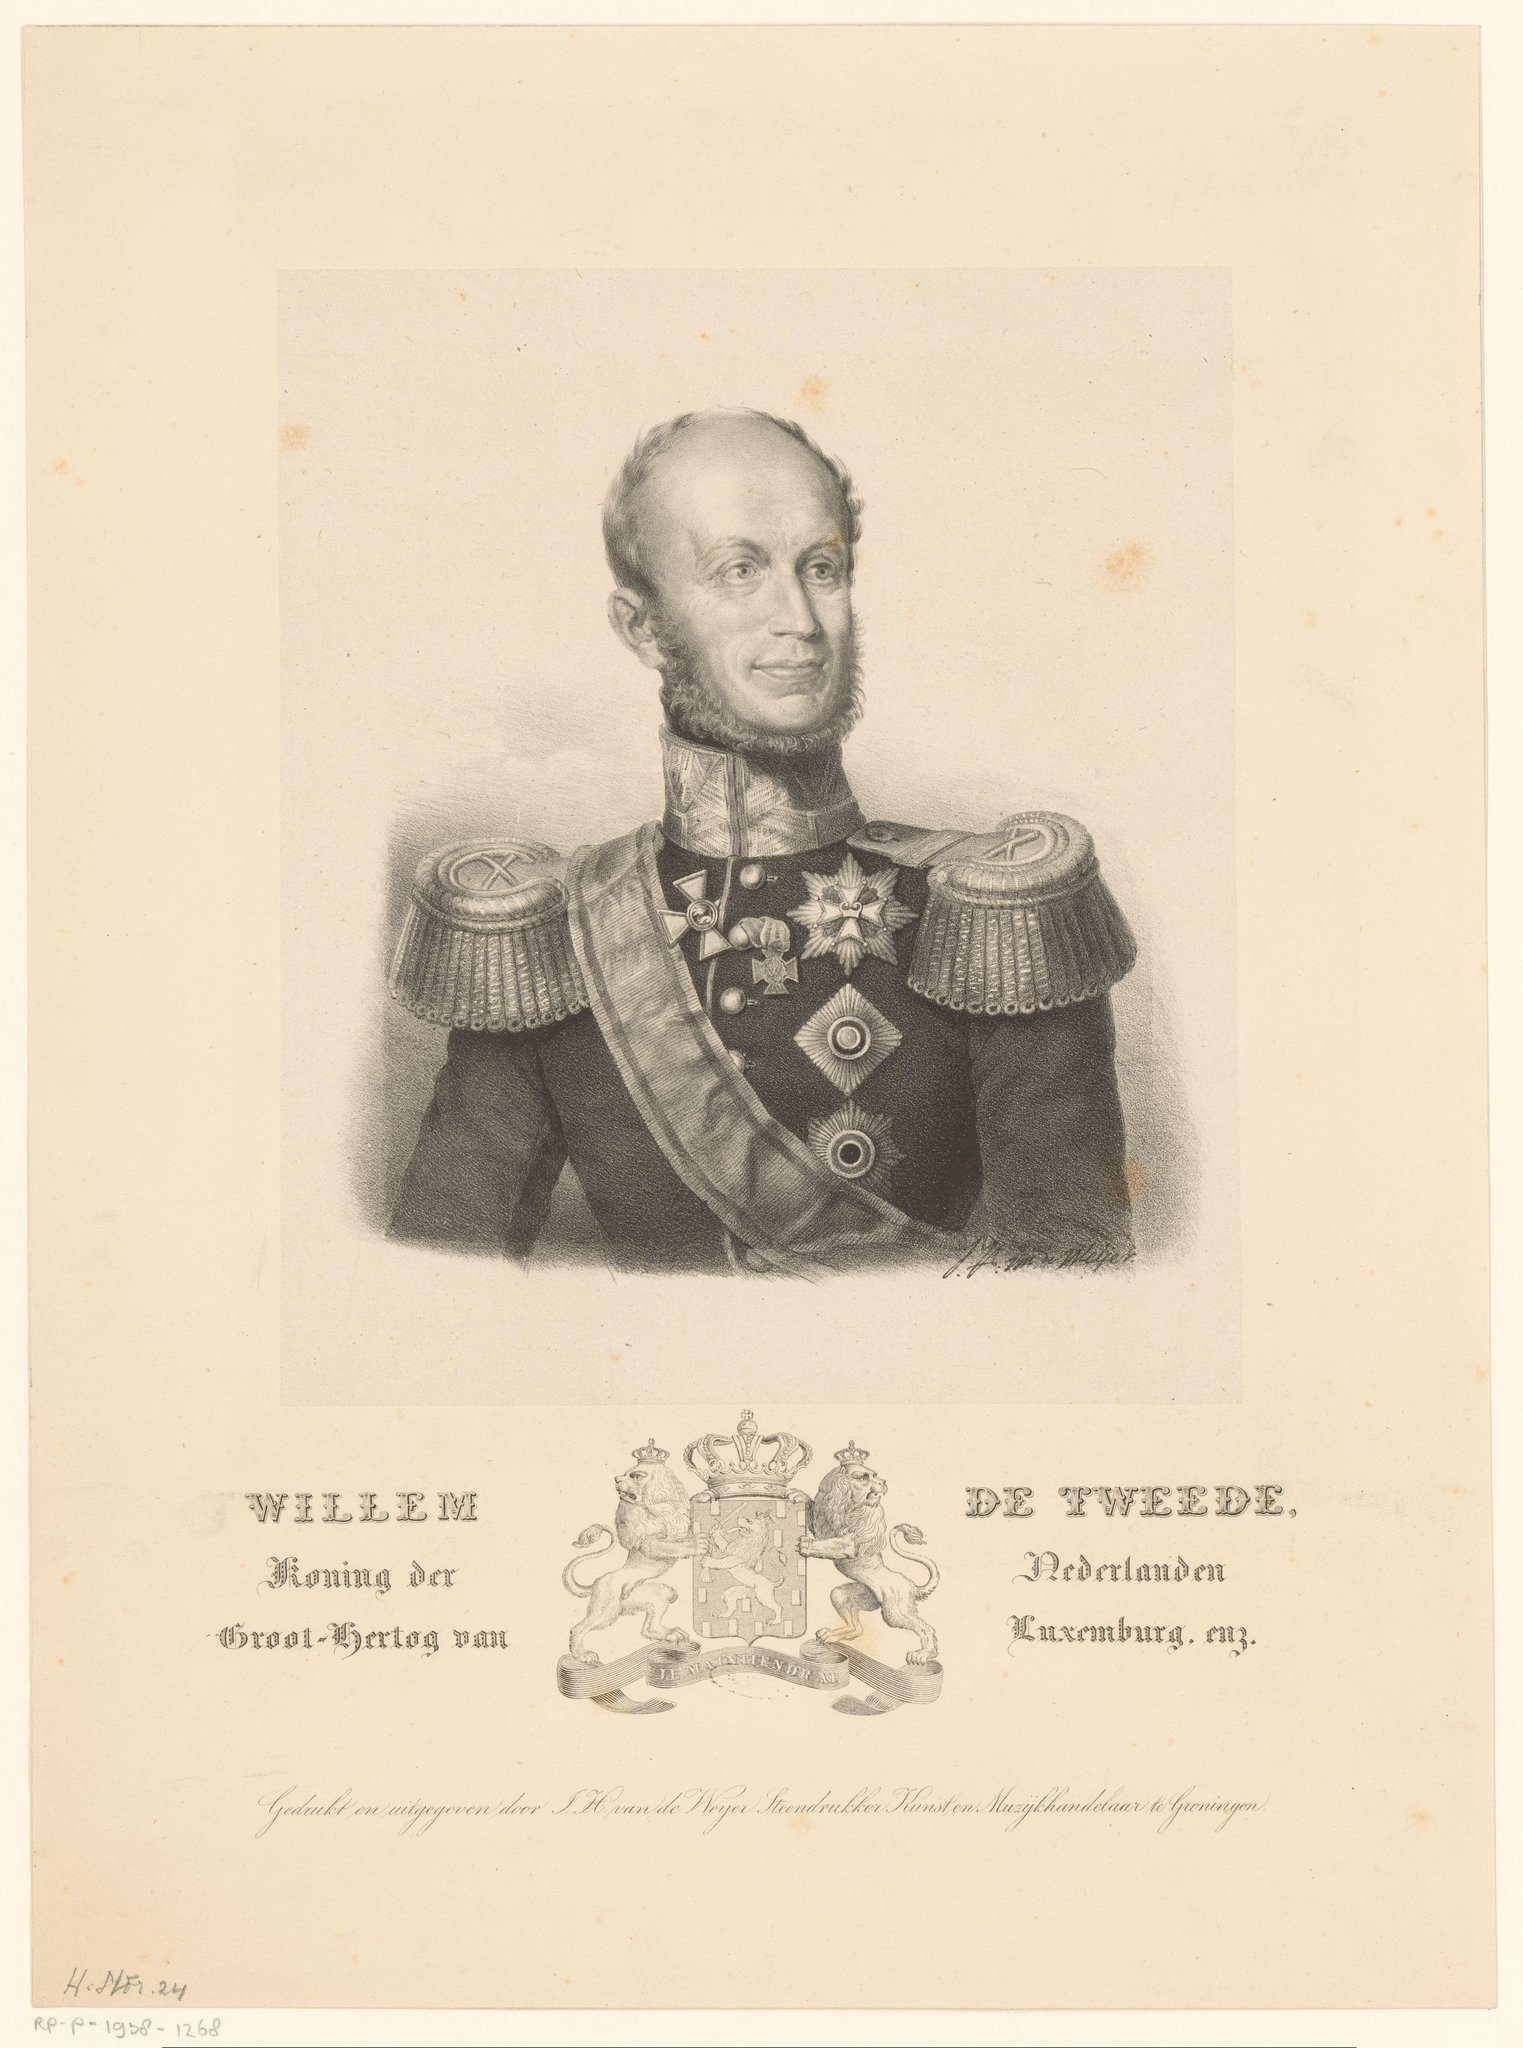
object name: print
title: Portret van Koning Willem II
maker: johannes hermanus van de weijer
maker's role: print maker, printer, publisher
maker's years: 1817-1889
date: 1840-1876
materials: paper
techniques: lithograph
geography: groningen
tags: william ii of the netherlands, historical persons (+ (full) bust portrait), armorial bearing, heraldry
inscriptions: collector's mark: Lugt 2228, collector's mark: Lugt 2760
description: Onder het portret het wapen van de familie Oranje Nassau.